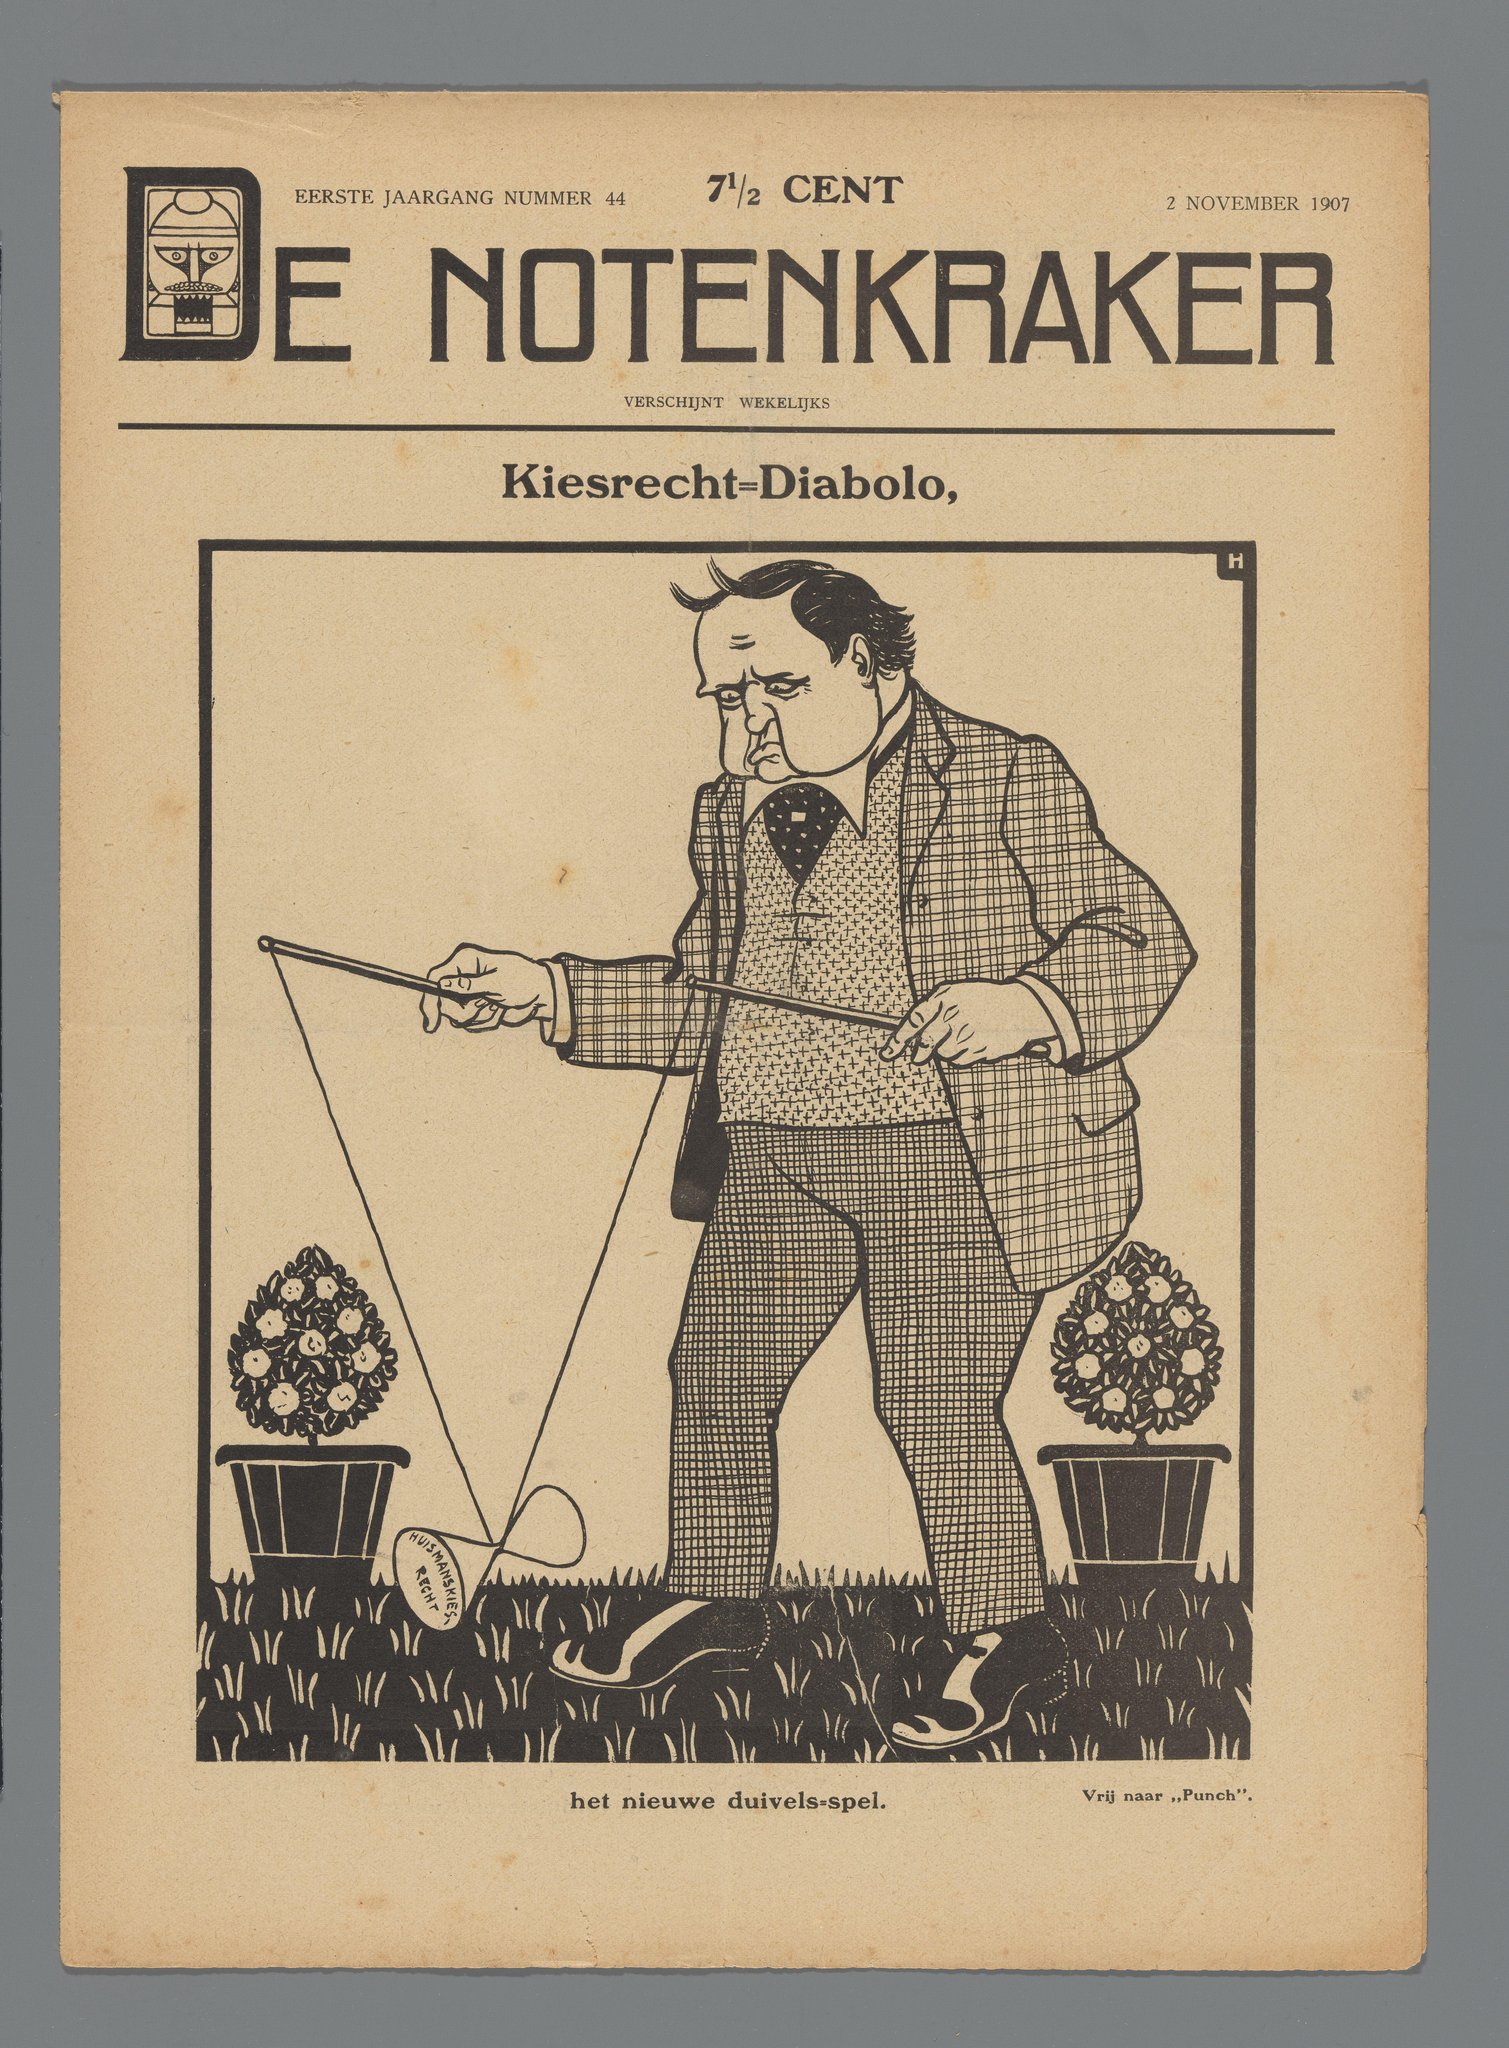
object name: print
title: De Notenkraker, 2 november 1907 / Kiesrecht-Diabolo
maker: albert hahn (i)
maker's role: draughtsman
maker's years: 1877-1918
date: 1907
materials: paper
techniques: lithograph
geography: netherlands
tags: the hague, abraham kuyper, air top, diabolo, devil-on-two-sticks, the right to vote, the compulsory vote, political caricatures and satires, netherlands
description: Aflevering van het satirische tijdschrift De Notenkraker van 2 november 1907, eerste jaargang, nummer 44. Omslag met illustratie van Abraham Kuyper spelend met een diabolo. Naar aanleiding van de politieke discussie over kiesrecht. Onderdeel van een volledige eerste jaargang (1907). Elk nummer bevat 8 bladzijden, deels nog niet losgesneden, met op de voorzijde steeds een spotprent van Albert Hahn, op de overige pagina's prenten van Hahn steeds tussen de tekst. In de letter 'D' van de titel is een kop van een zgn. notenkraker afgebeeld.